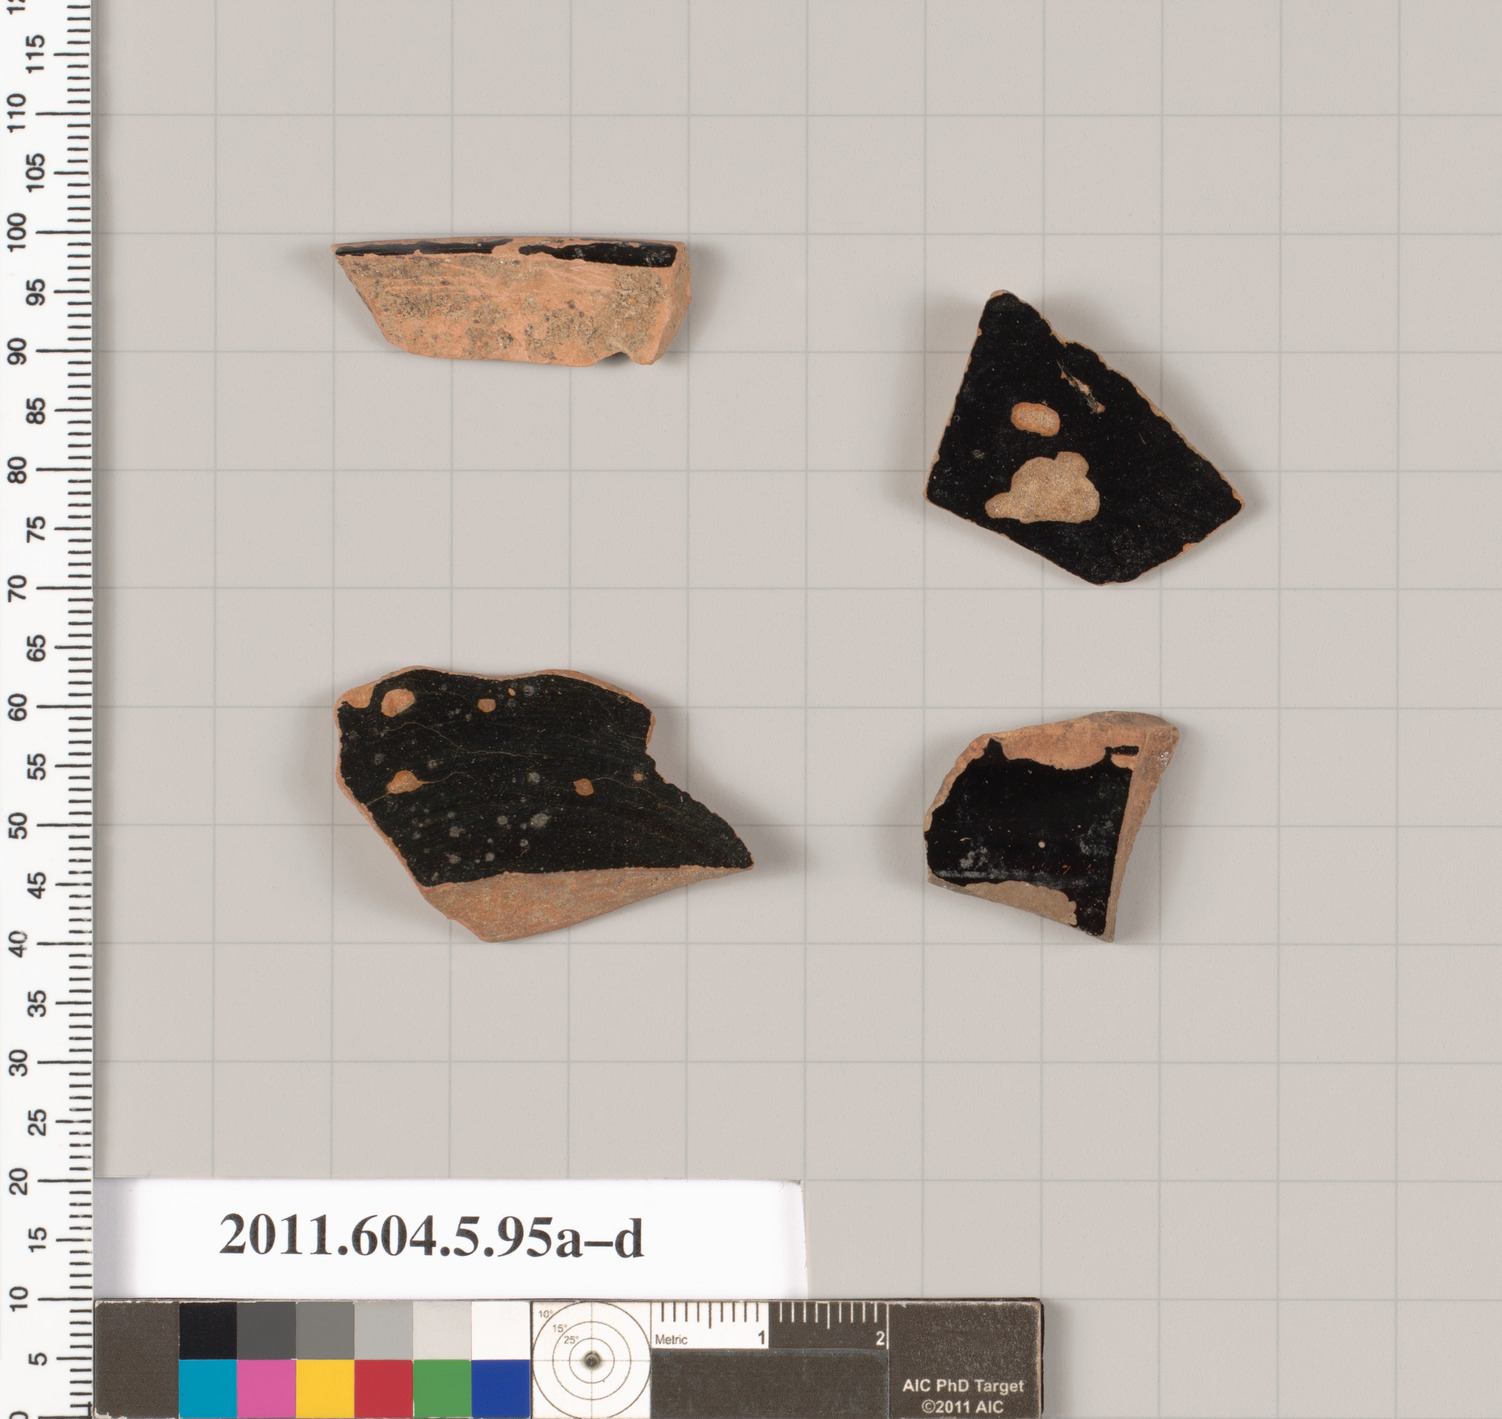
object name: kylix fragment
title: Terracotta fragments of kylikes (drinking cups)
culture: greek, attic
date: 475-451 BCE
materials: terracotta